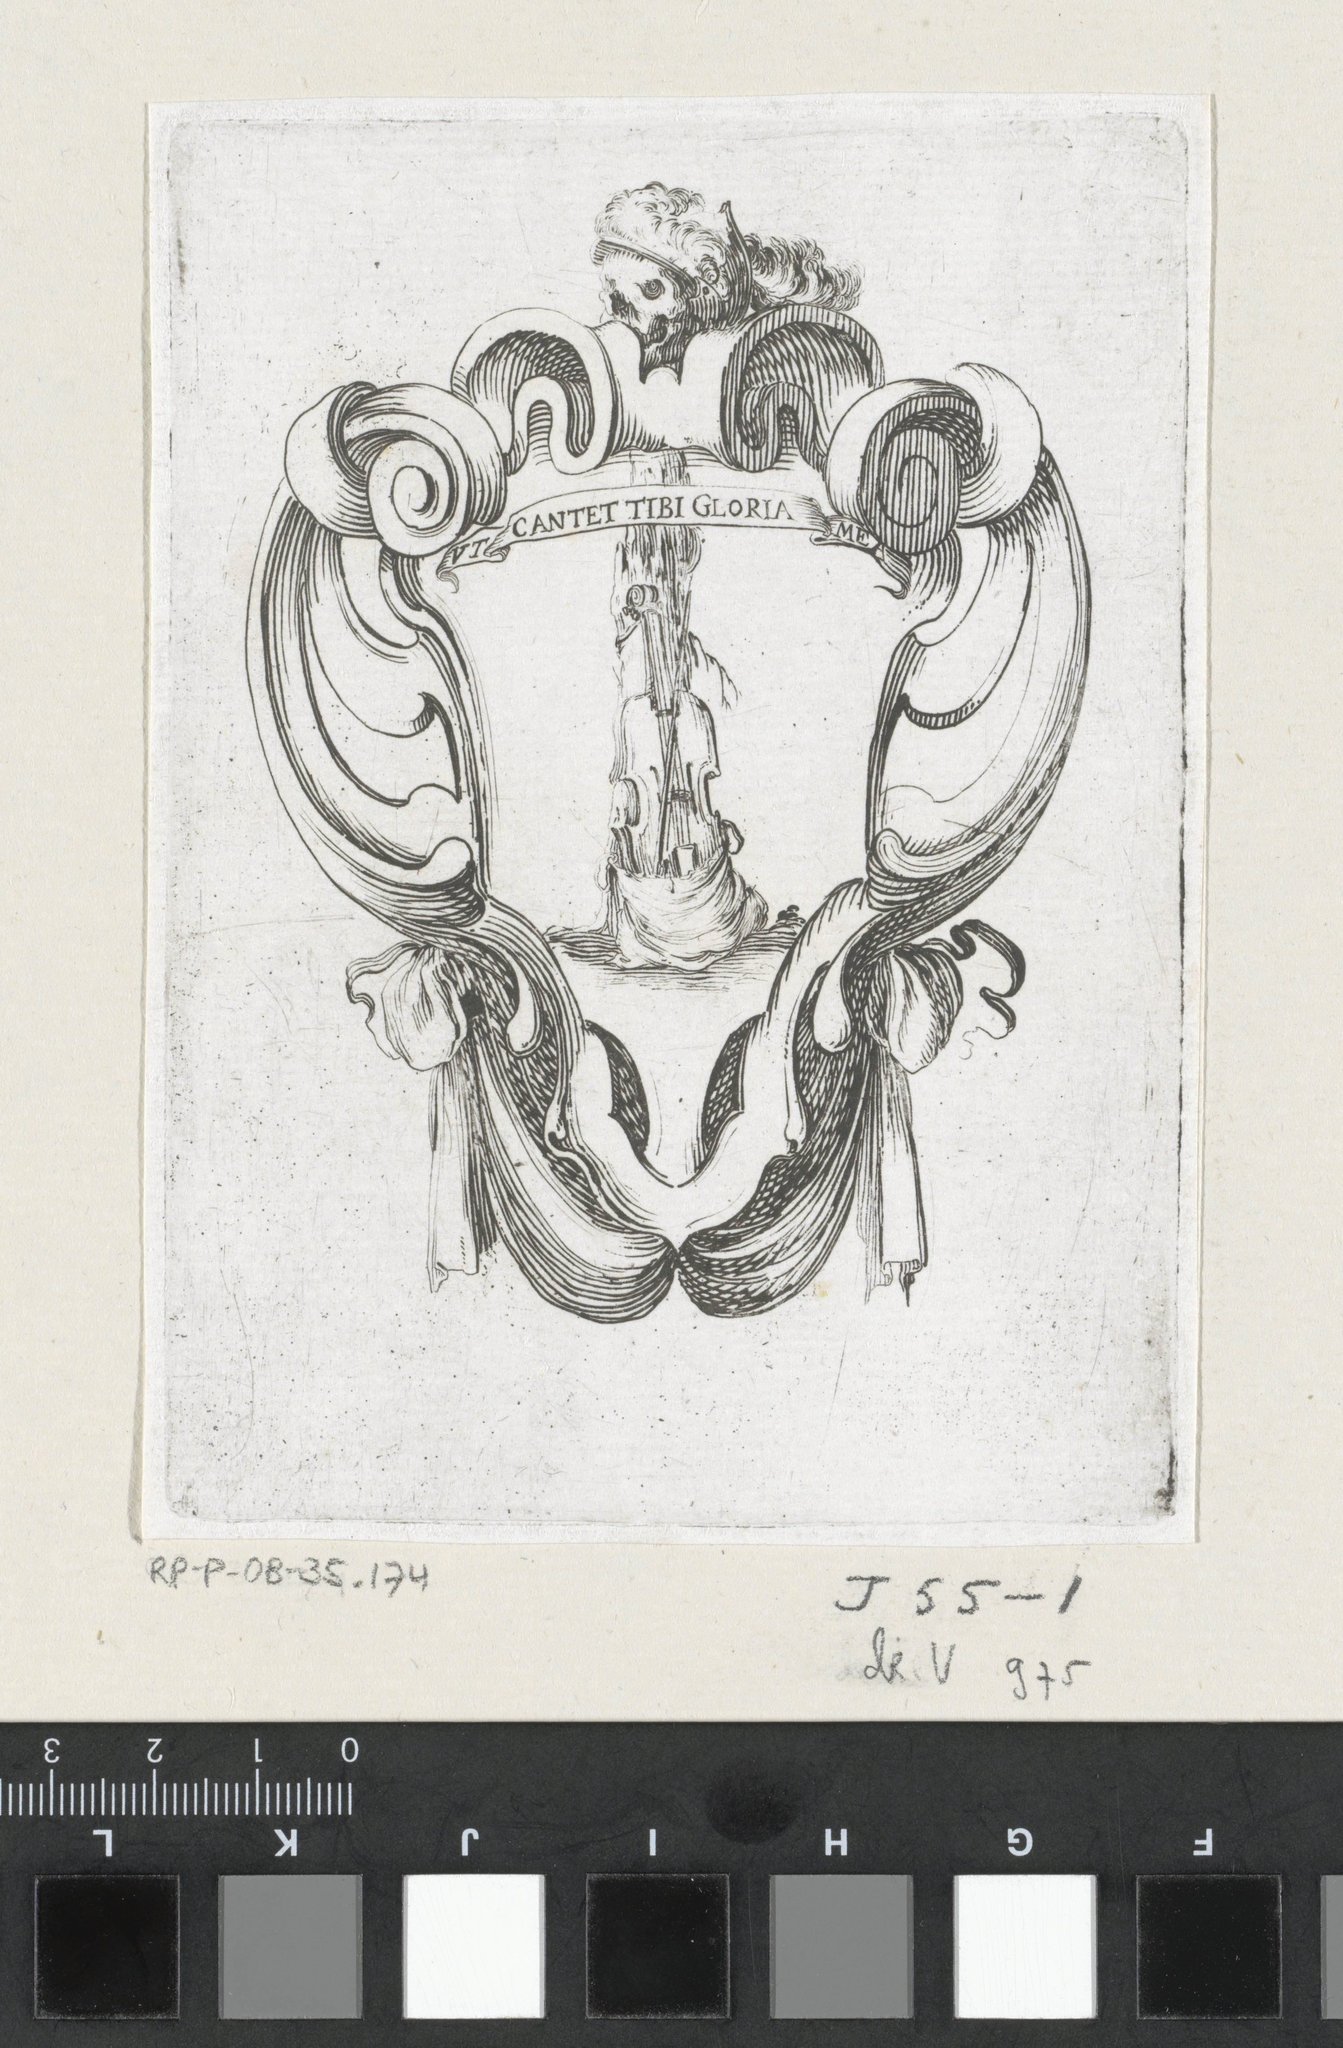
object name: print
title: Acht cartouches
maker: stefano della bella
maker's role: draughtsman, print maker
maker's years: 1610-1664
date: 1620-1664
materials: paper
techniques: etching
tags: (human) skull, violin, fiddle, ornament ~ cartouche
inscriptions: collector's mark: Lugt 240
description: Een cartouche met een viool, een banderol met tekst en bovenop een schedel met gevederde helm.